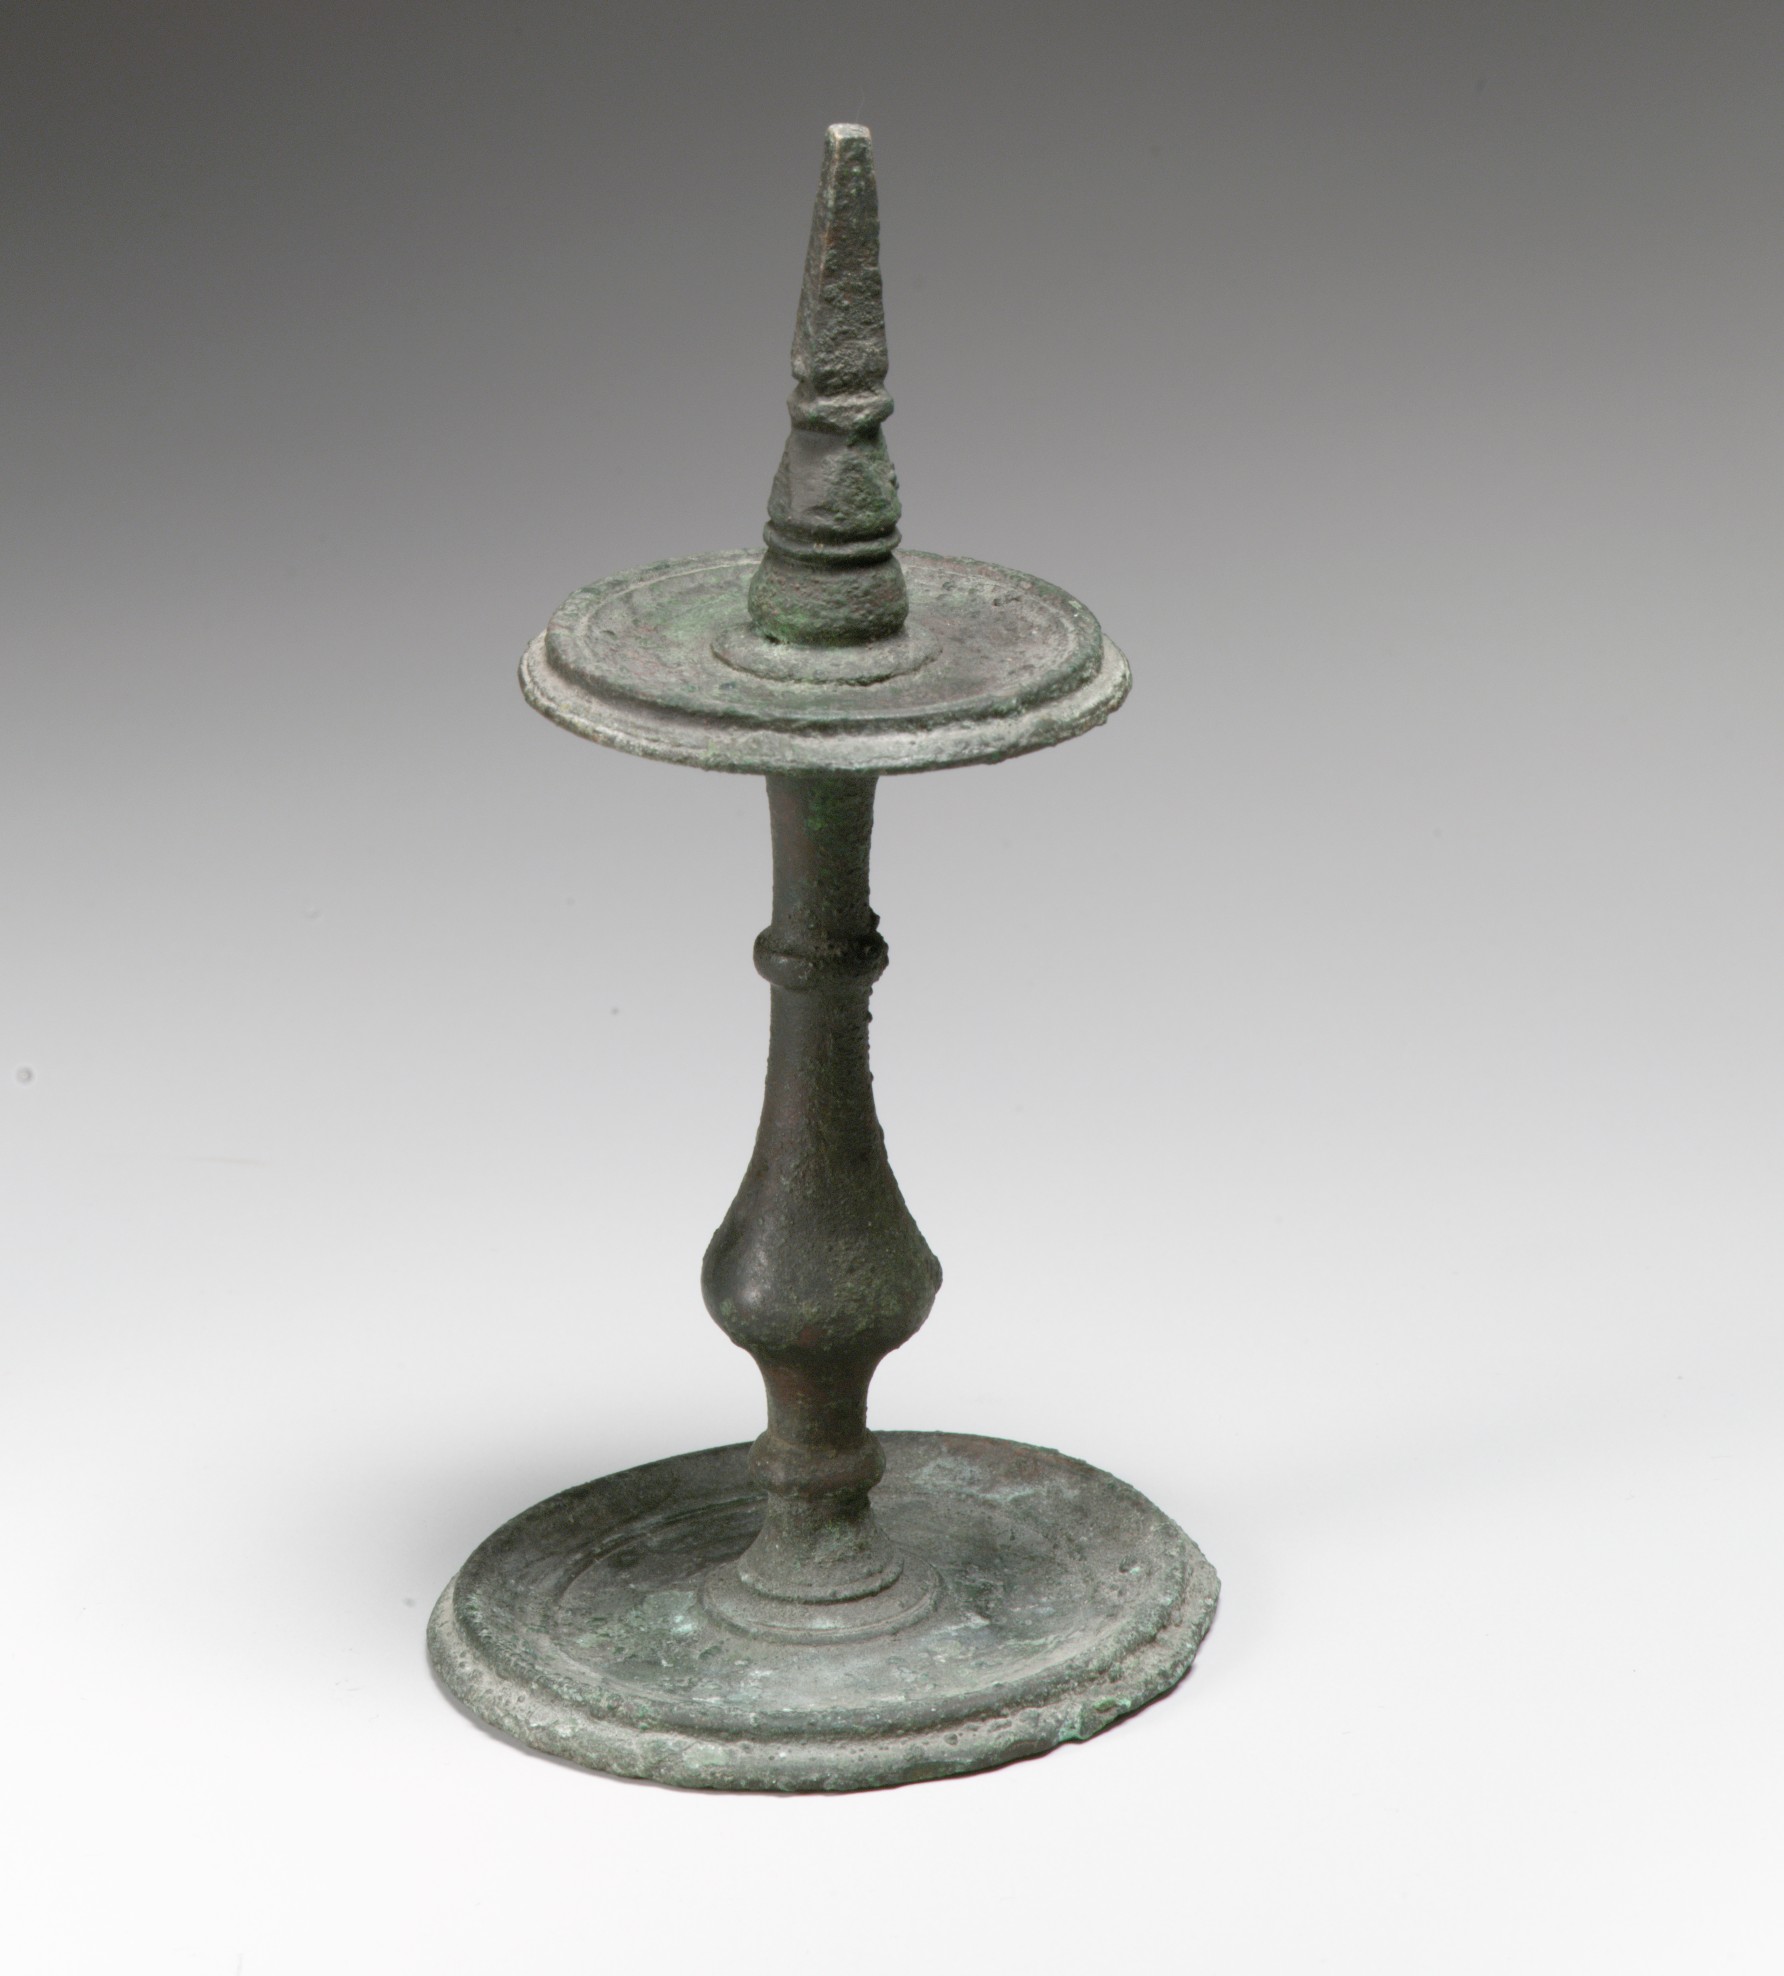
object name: lampstand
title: Bronze lampstand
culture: roman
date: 301-400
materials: bronze